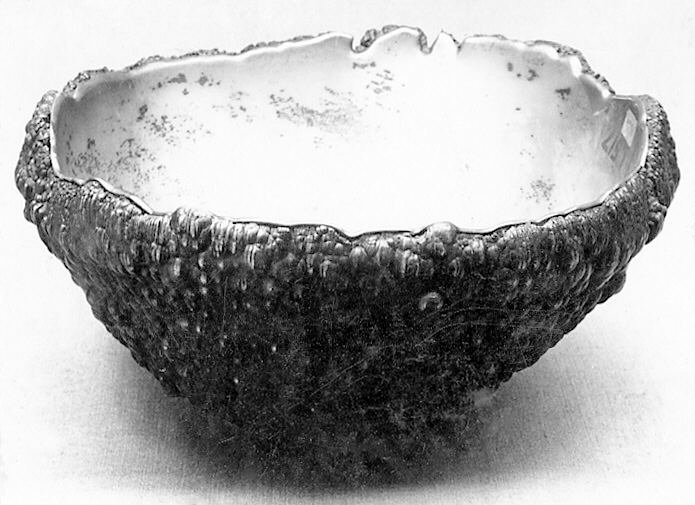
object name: cup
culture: japanese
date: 1801-1900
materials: copper, silver